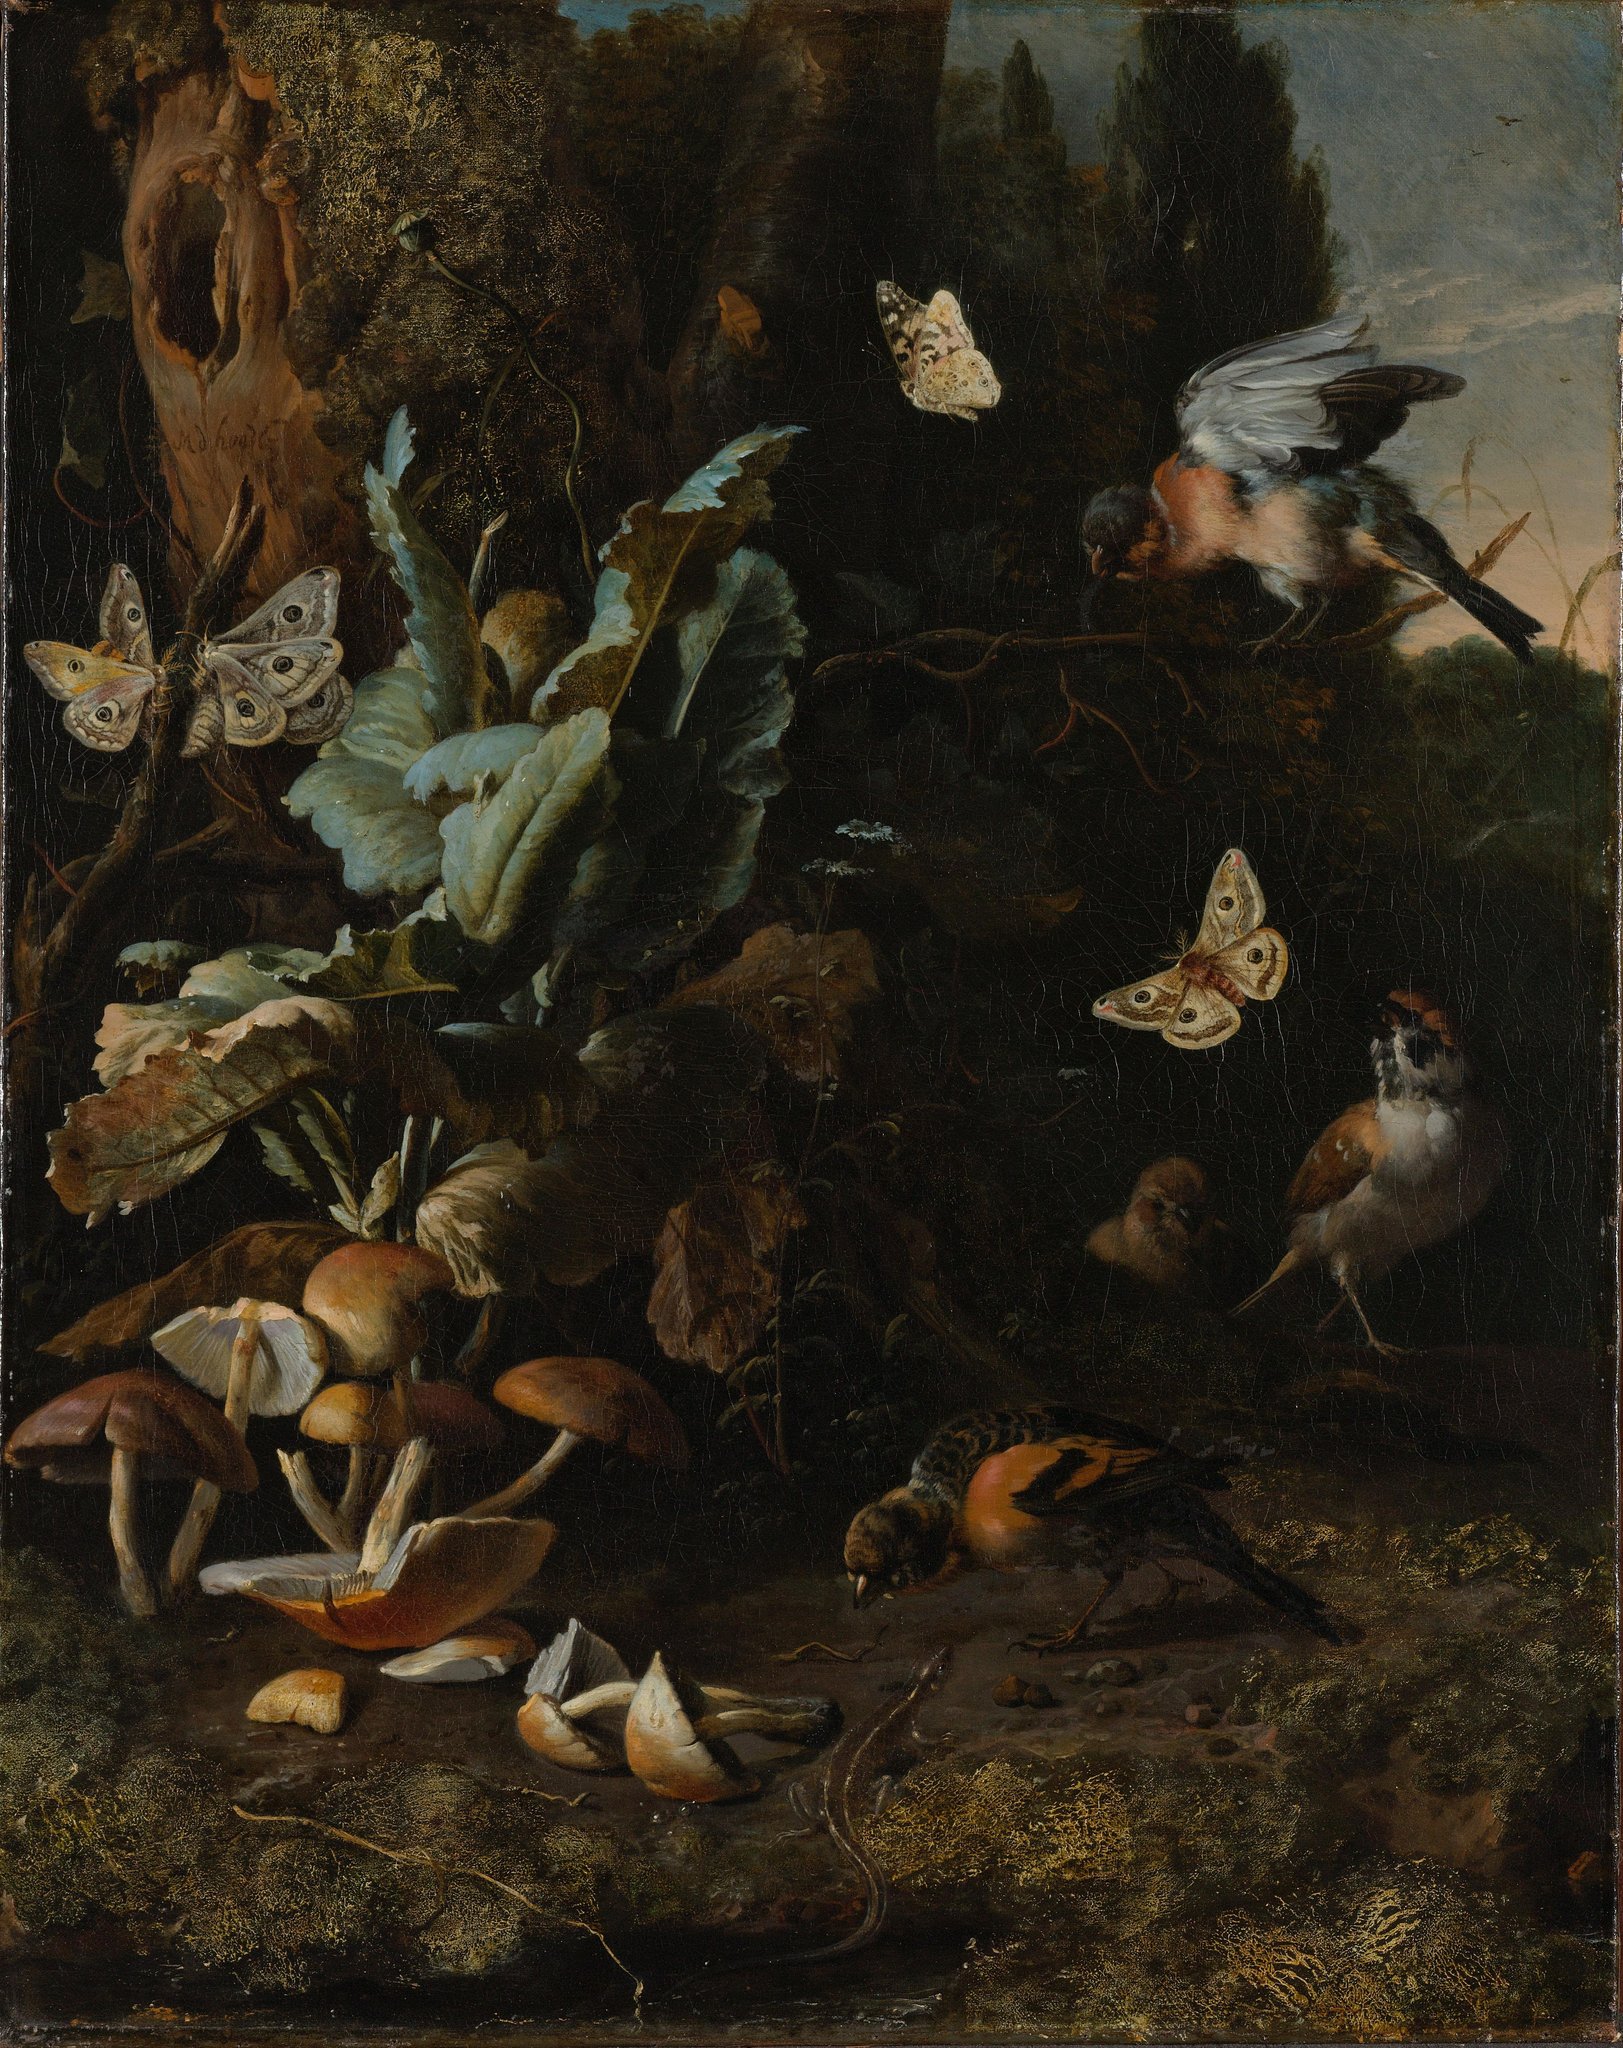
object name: painting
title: Animals and Plants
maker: melchior d hondecoeter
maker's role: draughtsman, painter, print maker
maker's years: 1636-1695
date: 1668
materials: canvas, oil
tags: birds, lizards: lizard, insects: butterfly, mushrooms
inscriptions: signature: ‘M d hondec’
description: D’Hondecoeter specialized in painting birds, which he portrayed as lifelike as possible, such as the chaffinch at the upper right in this still life. On this forest floor, in addition to birds, he painted butterflies and a common wall lizard. However, there is more to it than that. He used real butterfly wings for the butterflies and worked the wet paint with a sponge or cloth to suggest the moss, thereby creating an optimally realistic effect.